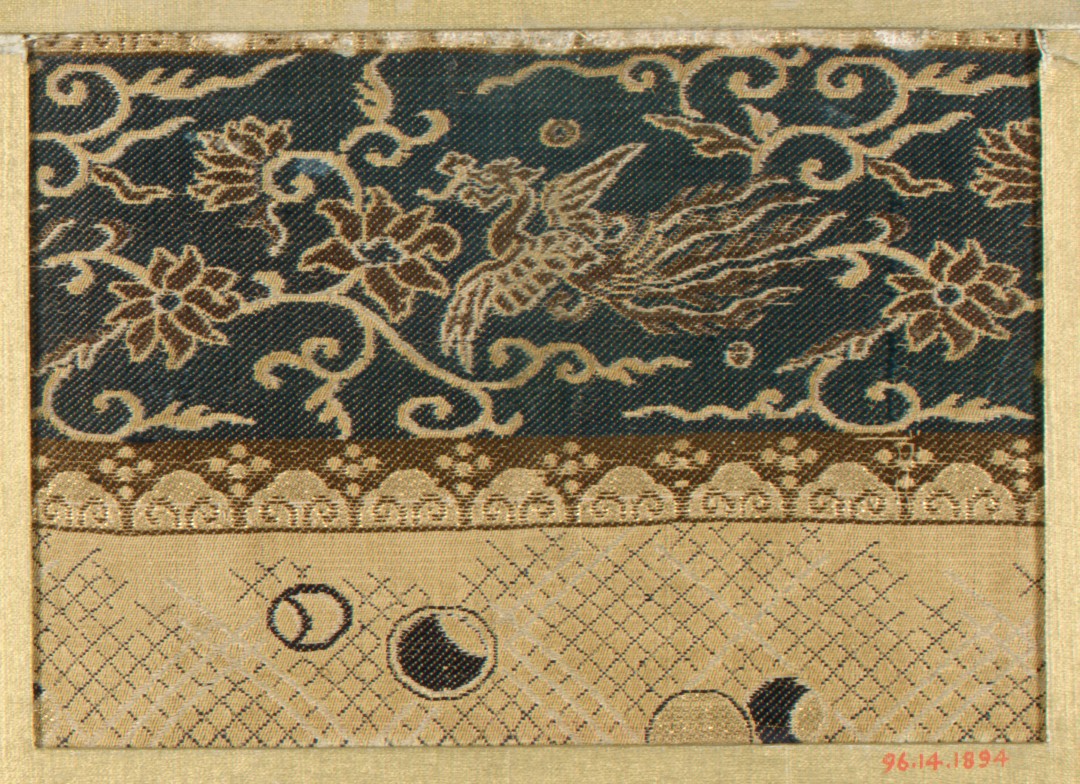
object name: piece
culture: japanese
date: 1701-1900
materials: silk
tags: mythical creatures